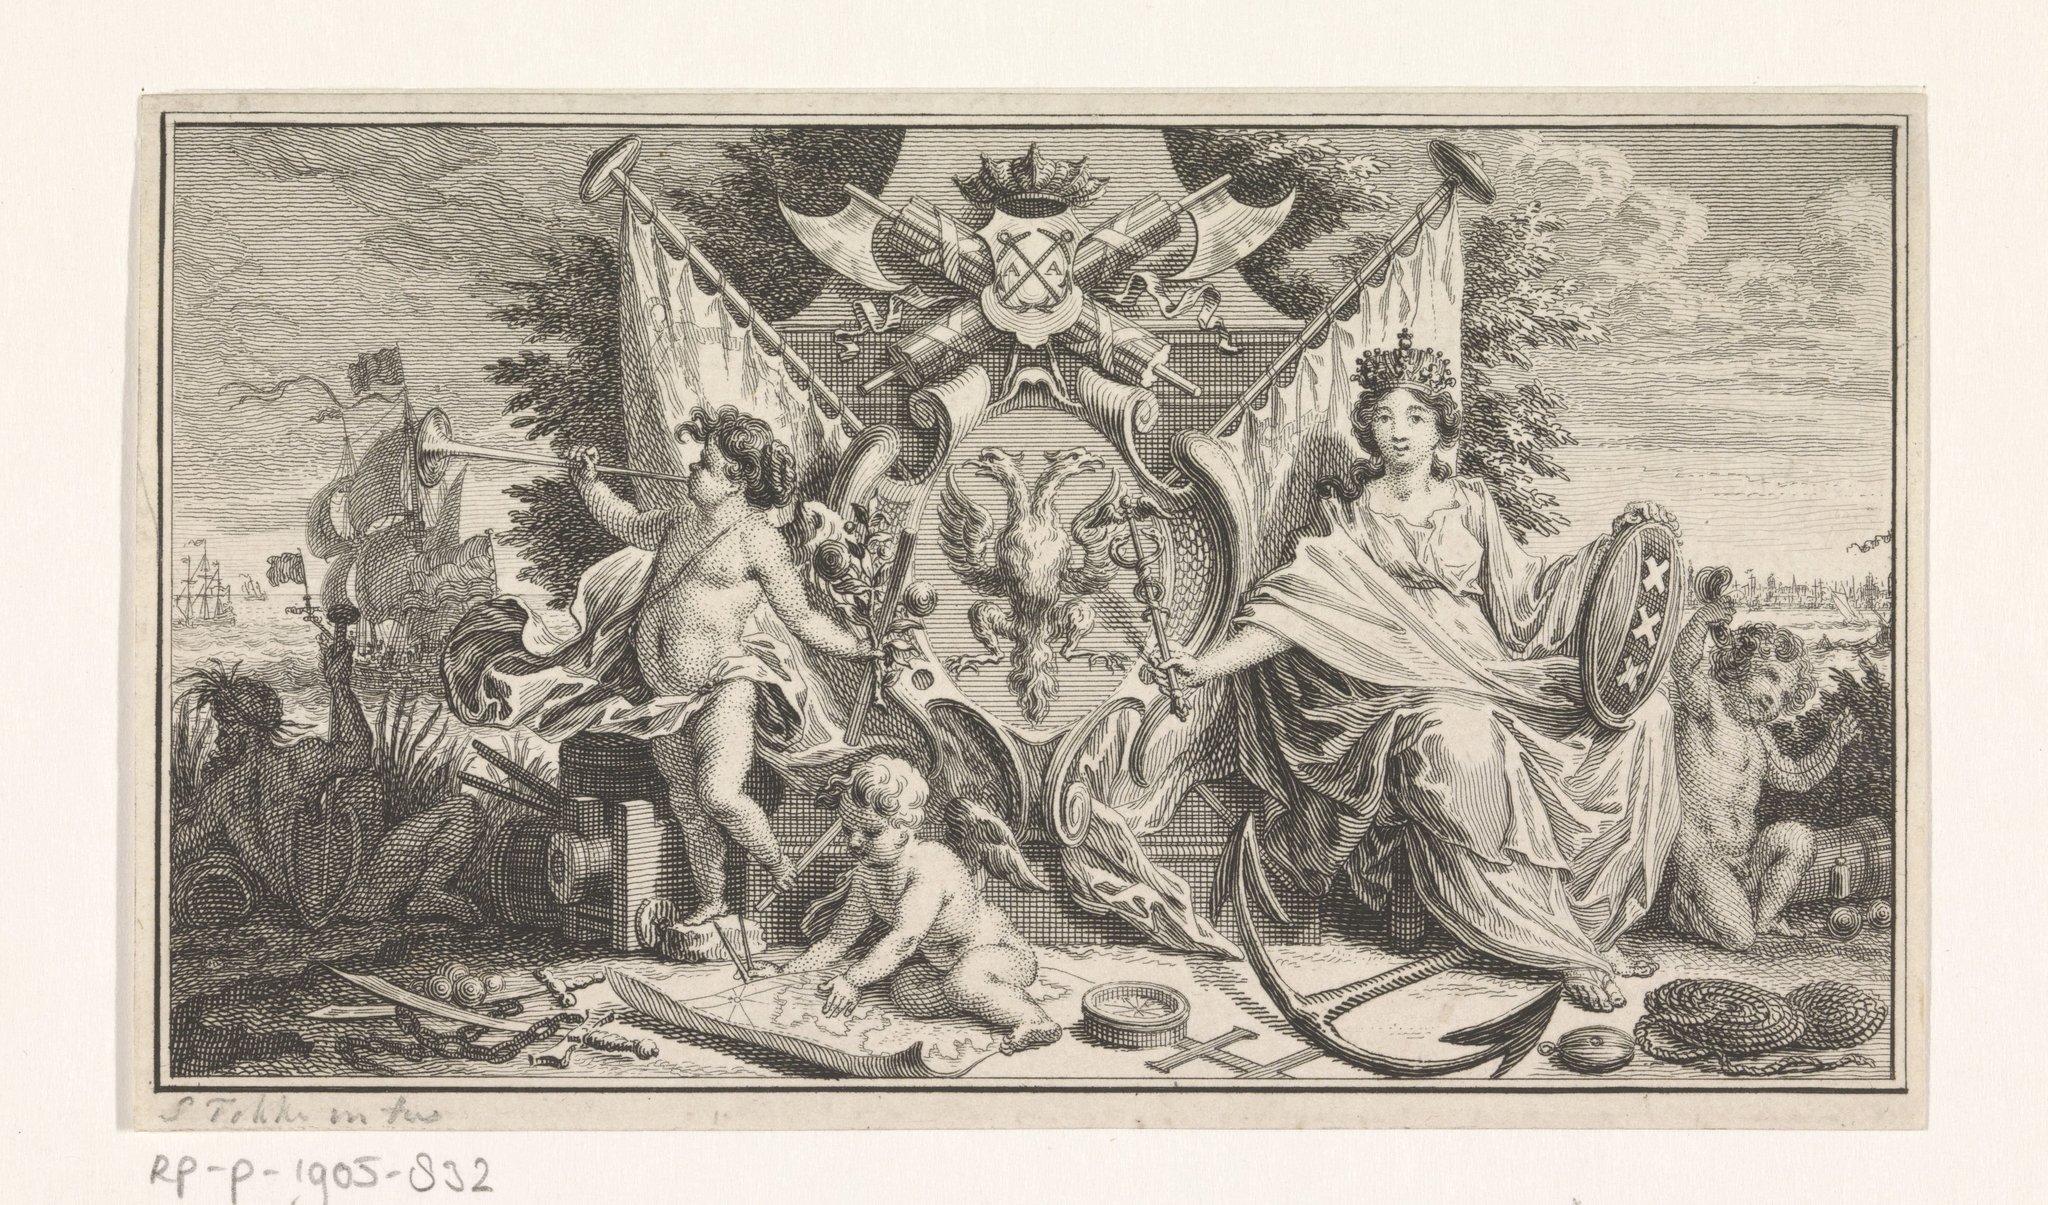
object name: print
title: Amsterdamse Stedenmaagd bij een wapenschild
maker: simon fokke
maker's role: draughtsman, print maker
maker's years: 1712-1784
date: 1749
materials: paper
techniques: etching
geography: amsterdam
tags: double-headed eagle, personification of a city, town-patron(ess), fame; 'fama', 'fama buona', 'fama chiara' (ripa), amsterdam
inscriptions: collector's mark: Lugt 2228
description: De gekroonde Amsterdamse Stedenmaagd met het wapen van Amsterdam in haar hand houdt de caduceus voor een wapenschild met de beeltenis van een tweekoppige adelaar, gekroond met gekruisde bijlen. Aan de andere kant van het wapenschild blaast een putto de bazuin.